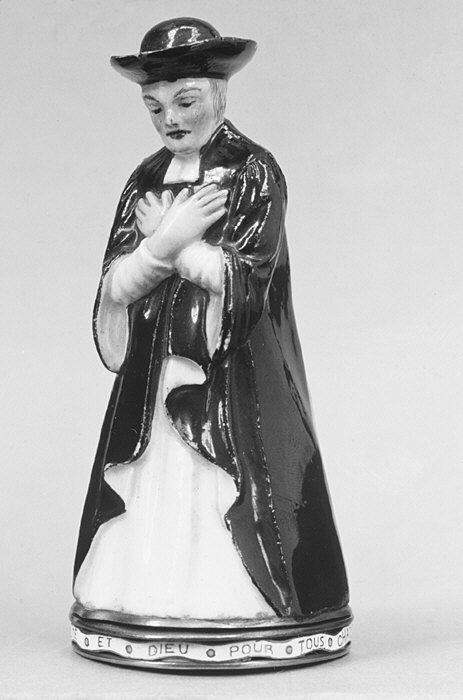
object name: scent bottle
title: Scent bottle in the form of a monk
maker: meissen manufactory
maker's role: manufactory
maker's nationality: german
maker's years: 1710-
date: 1730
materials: hard paste porcelain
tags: men,monks